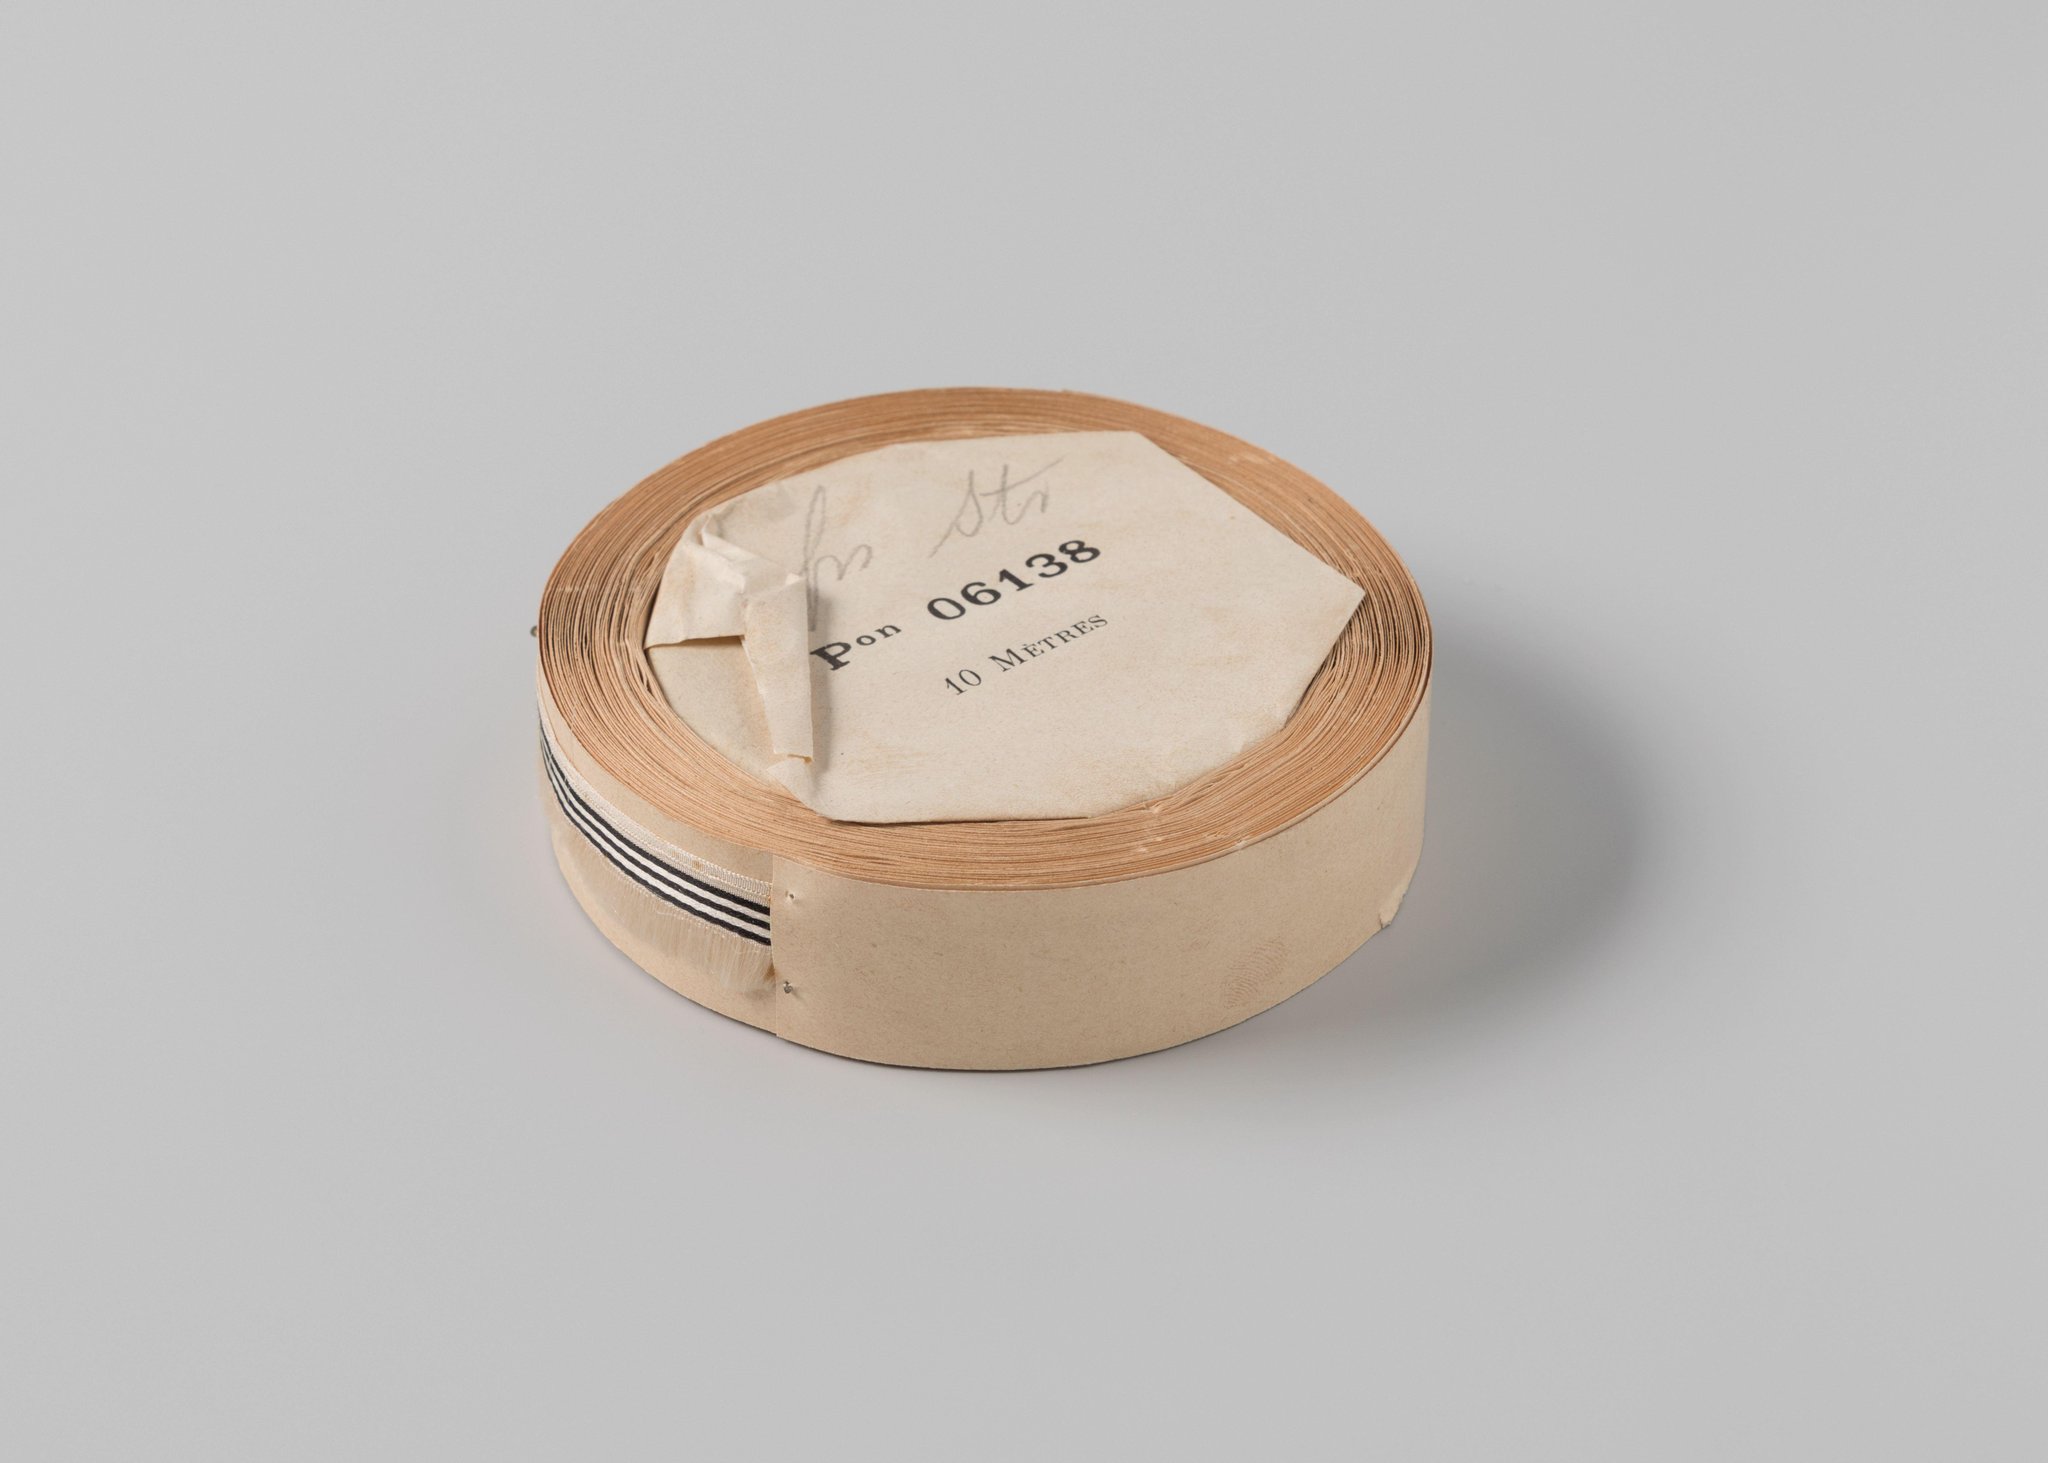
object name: ribbon material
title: Rol met wit lint met één gerafelde zijde en drie zwarte horizontale strepen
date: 1930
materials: cardboard, paper, textile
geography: france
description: Rol met wit lint met één gerafelde zijde en drie zwarte horizontale strepen.